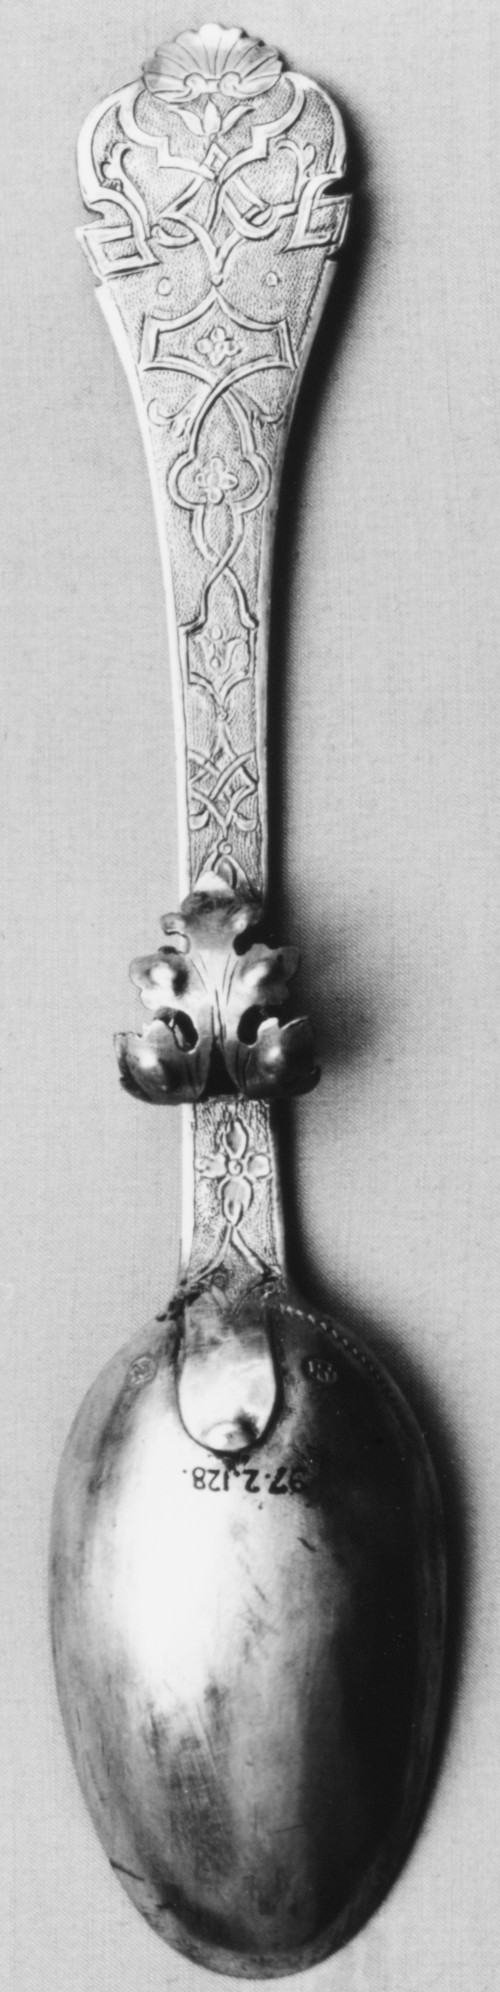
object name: spoon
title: Split-top spoon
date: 1767-1800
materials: silver